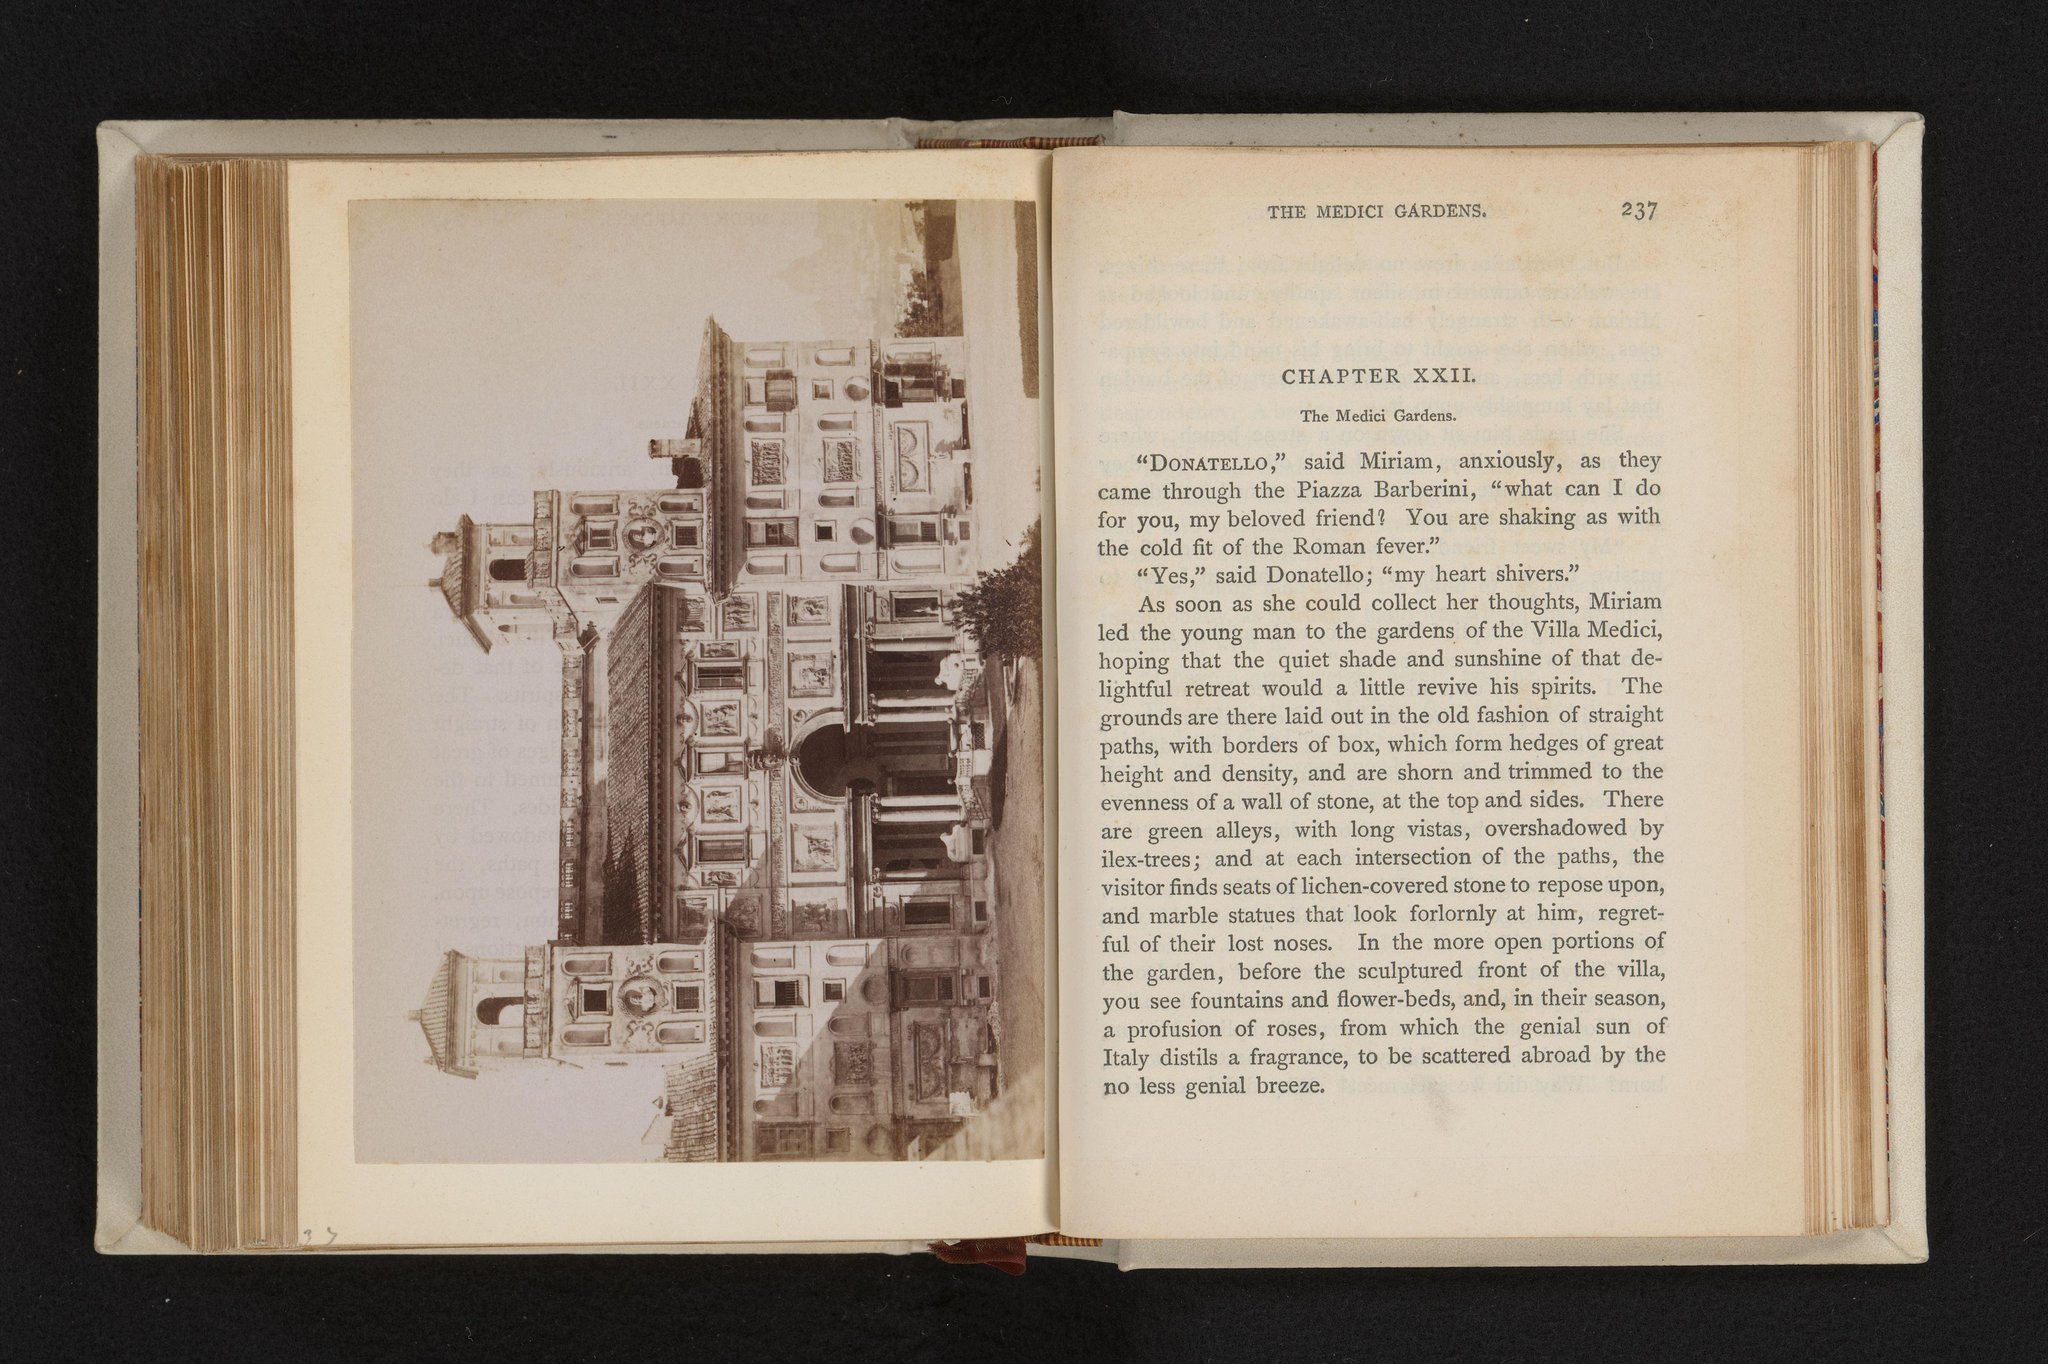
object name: photograph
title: Gezicht op de Villa Medici in Rome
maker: Anonymous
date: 1850-1860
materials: photographic support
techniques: albumen print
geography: rome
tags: villa